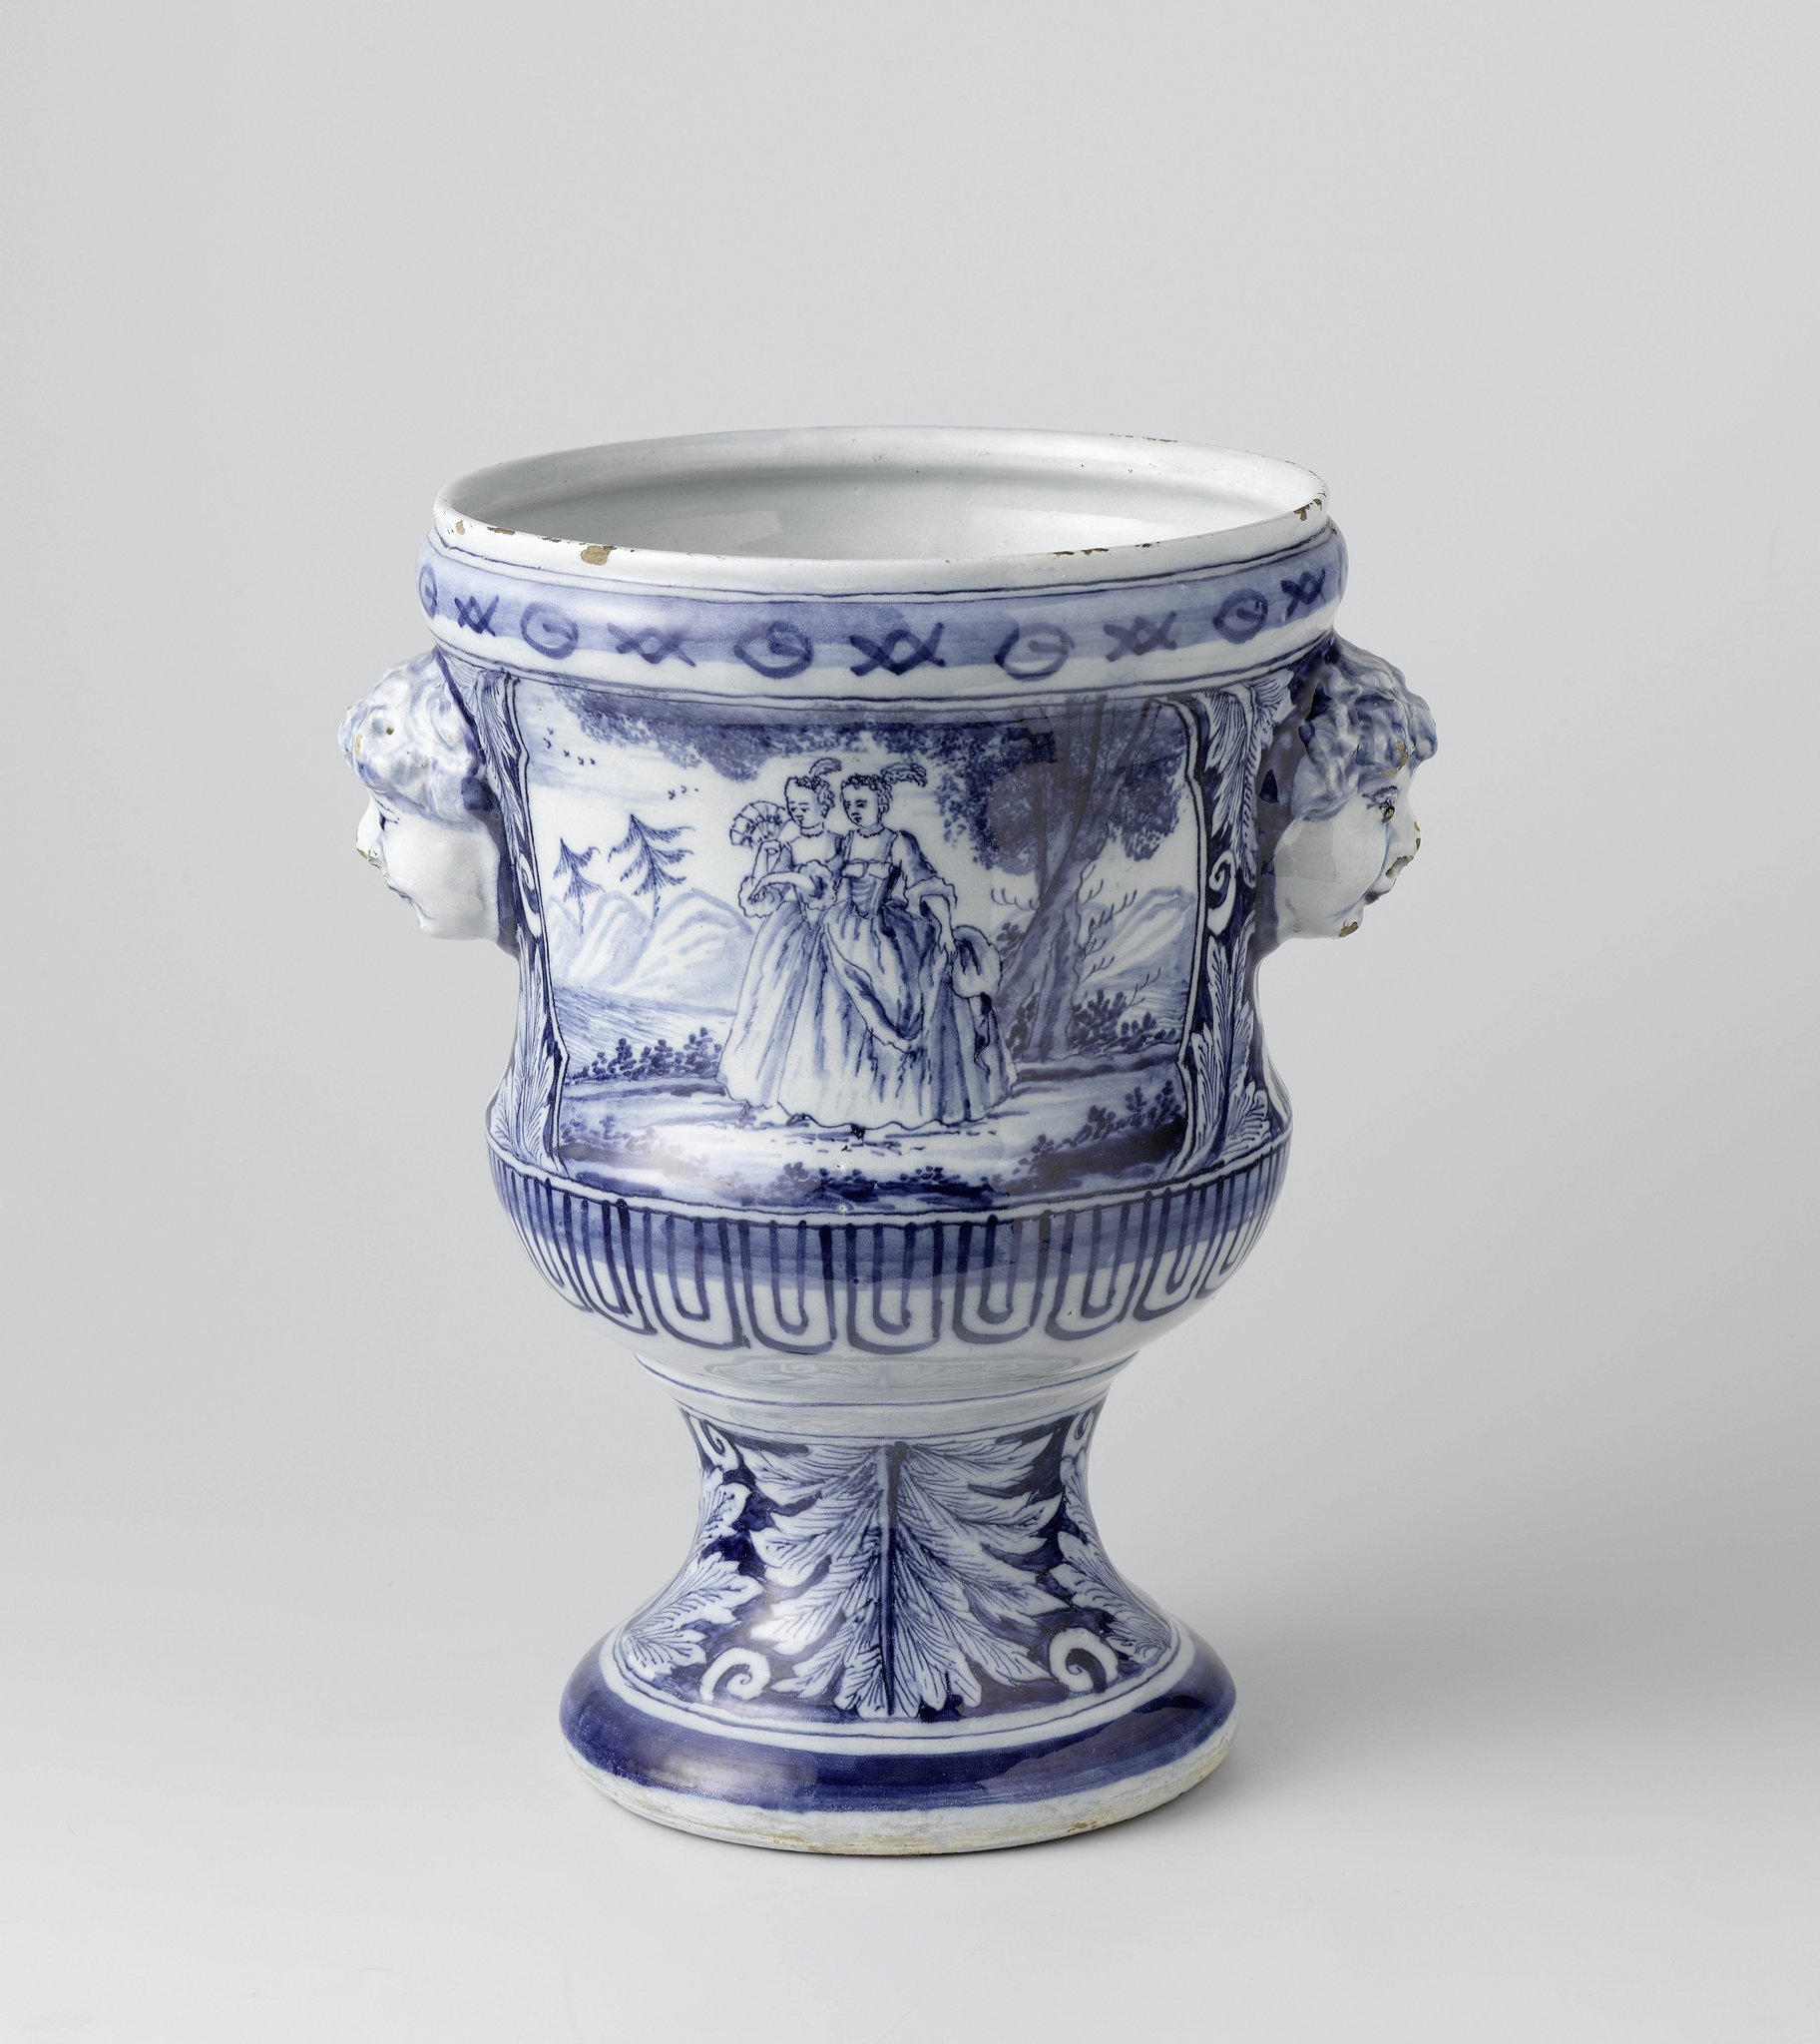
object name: cachepot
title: Two flower pot holders (cache-pots)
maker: Anonymous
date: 1730-1770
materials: earthenware, glaze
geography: delft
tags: walking, hiking (recreation)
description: Bloempothouder van faïence. Met oren in de vorm van kinderkopjes. Blauw beschilderd met landschappen.